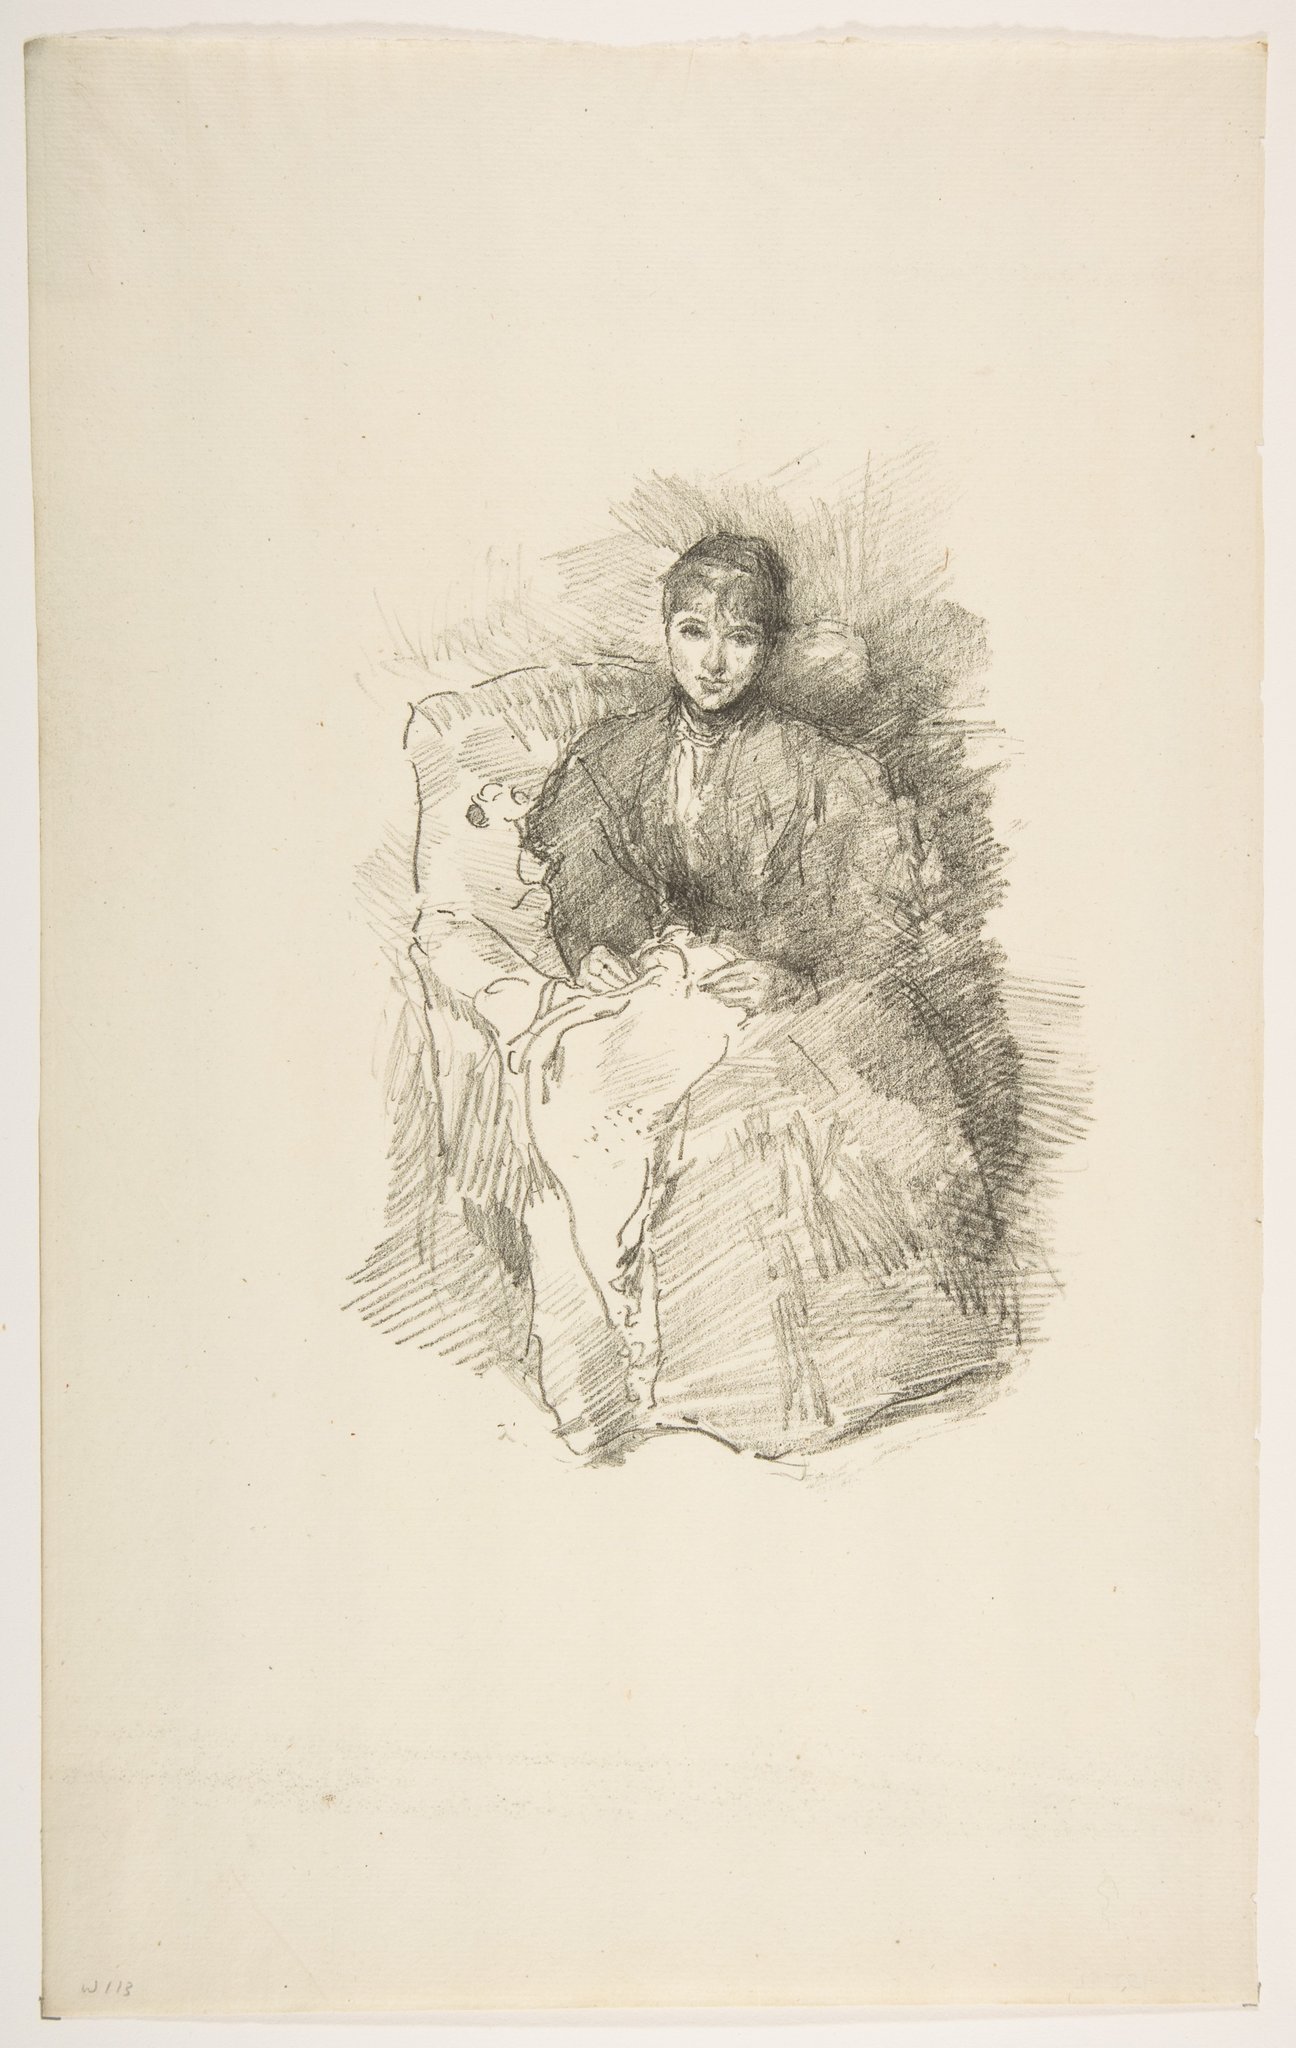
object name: print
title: Needlework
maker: james mcneill whistler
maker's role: artist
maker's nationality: american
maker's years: 1834-1903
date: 1896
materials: ink, paper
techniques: printing, lithography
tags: women